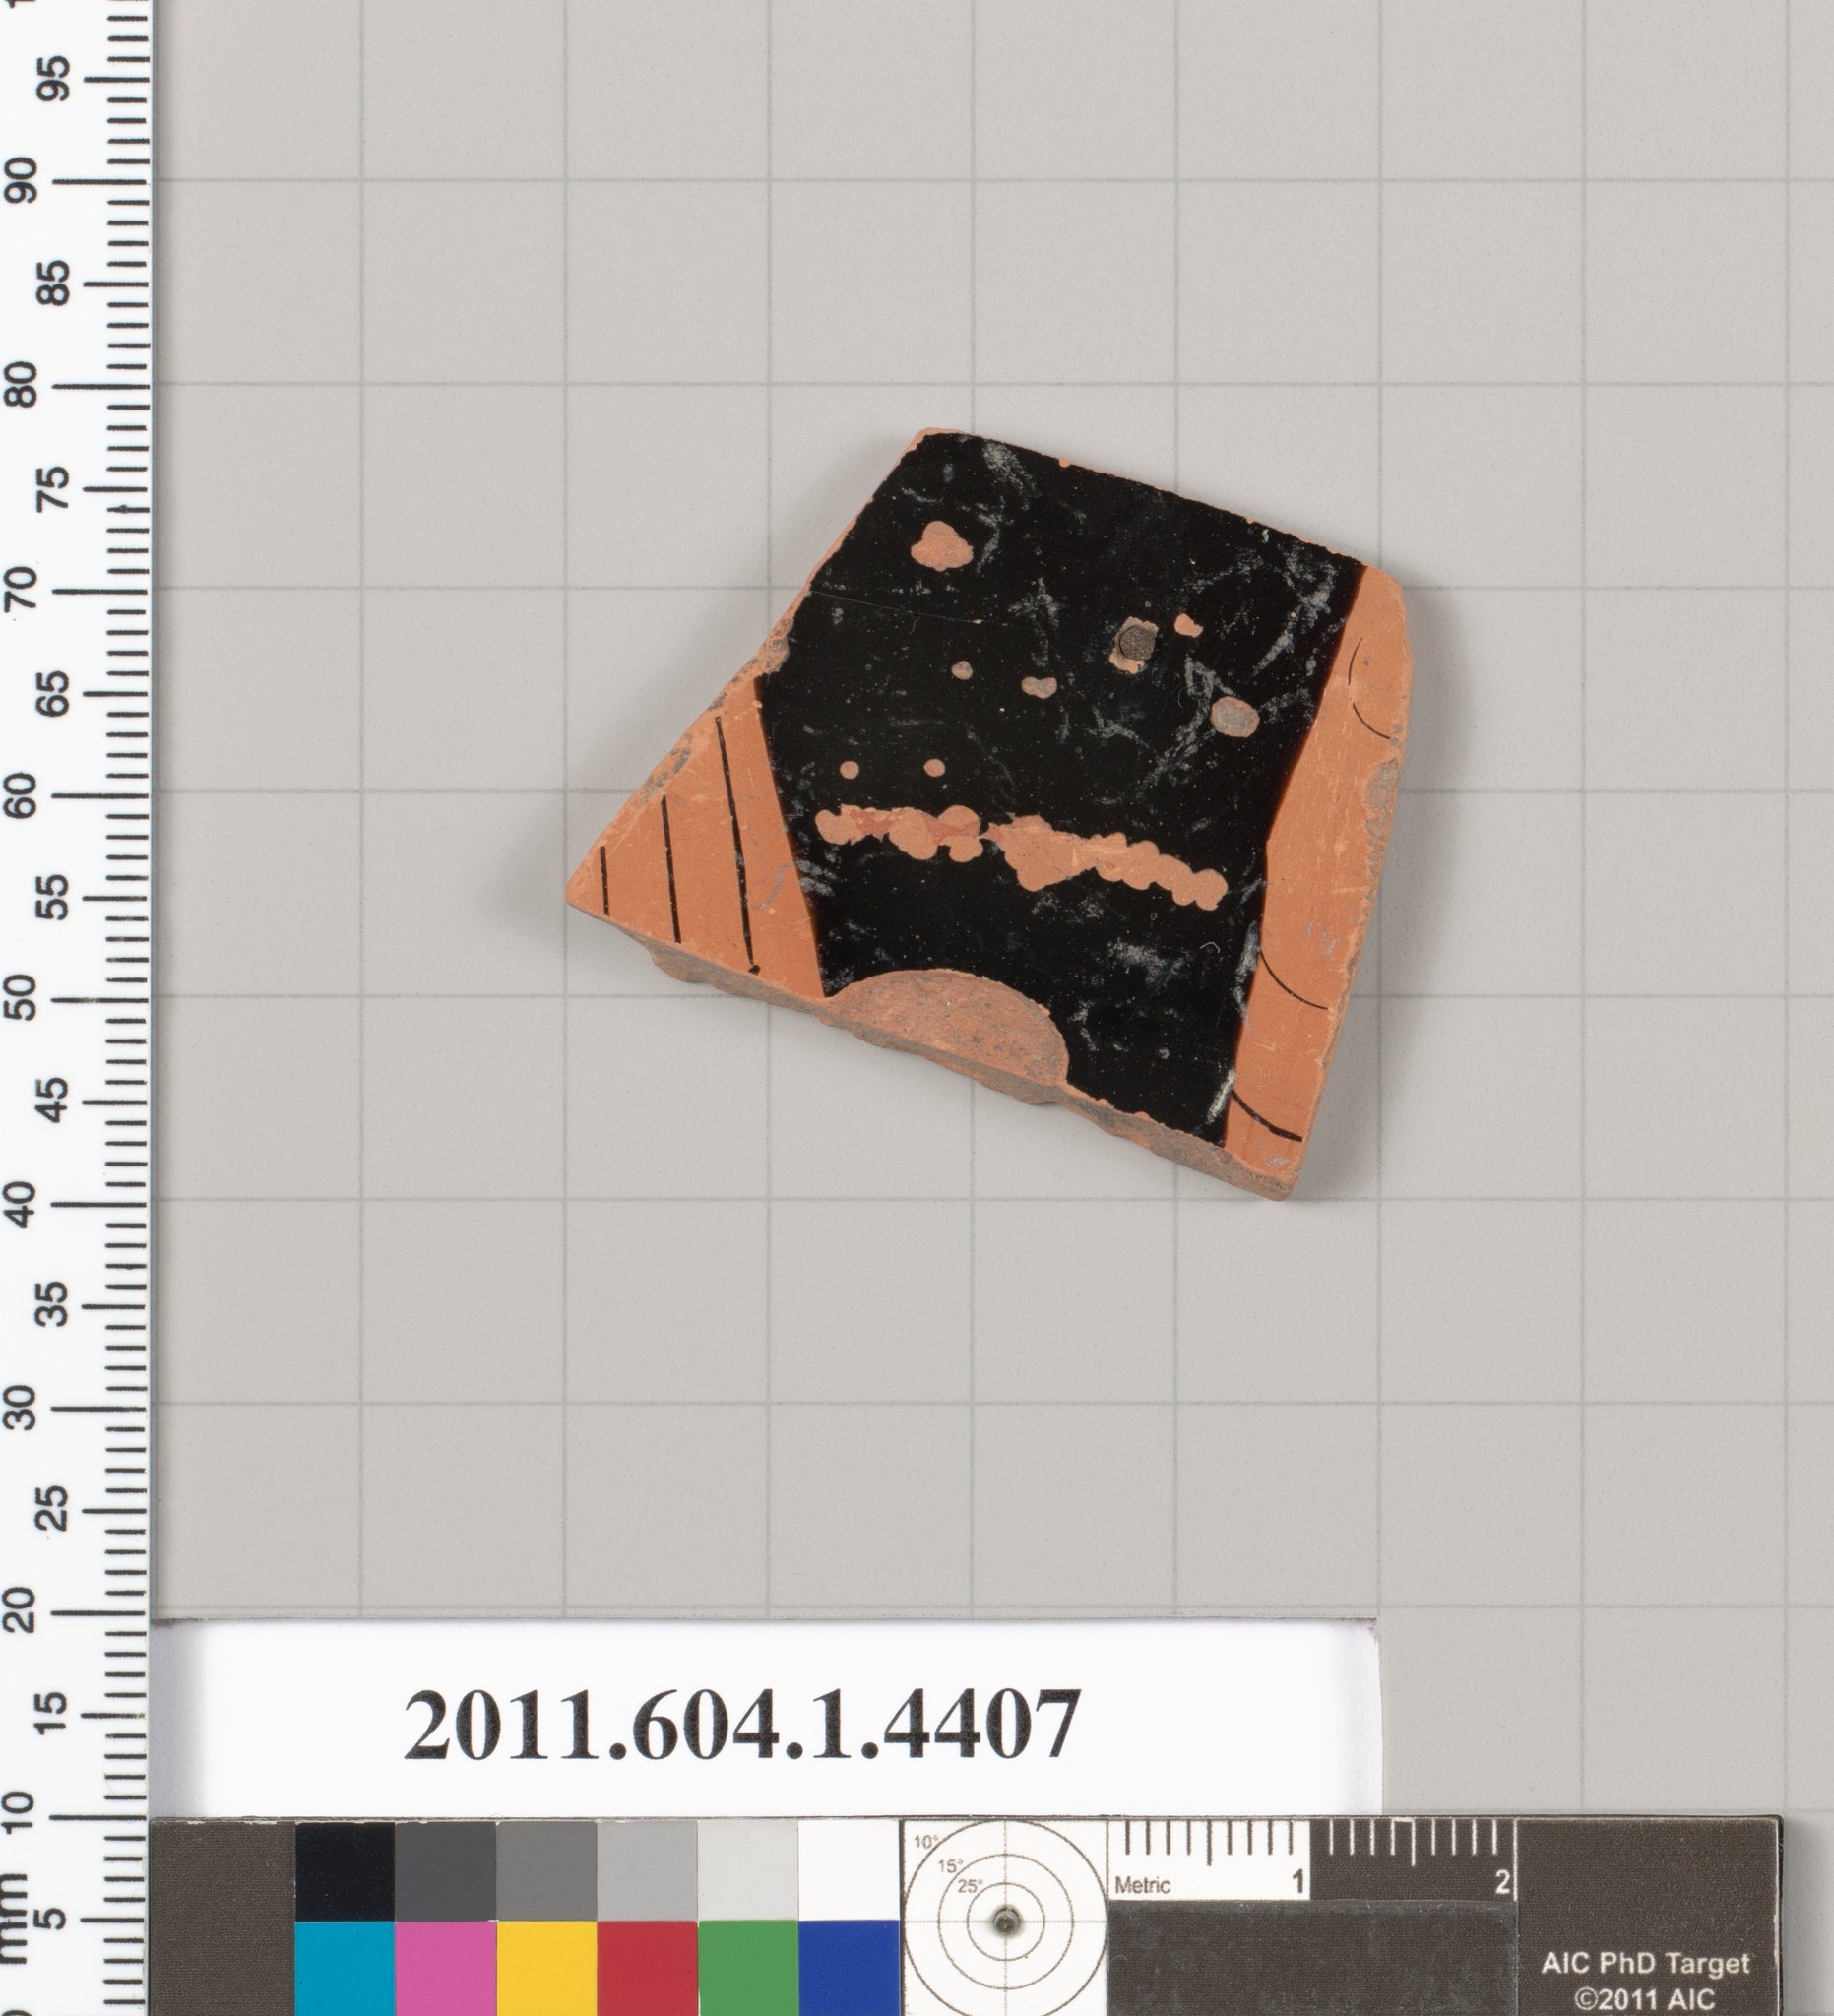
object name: kylix fragment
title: Terracotta fragment of a kylix (drinking cup)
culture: greek, attic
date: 475-451 BCE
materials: terracotta